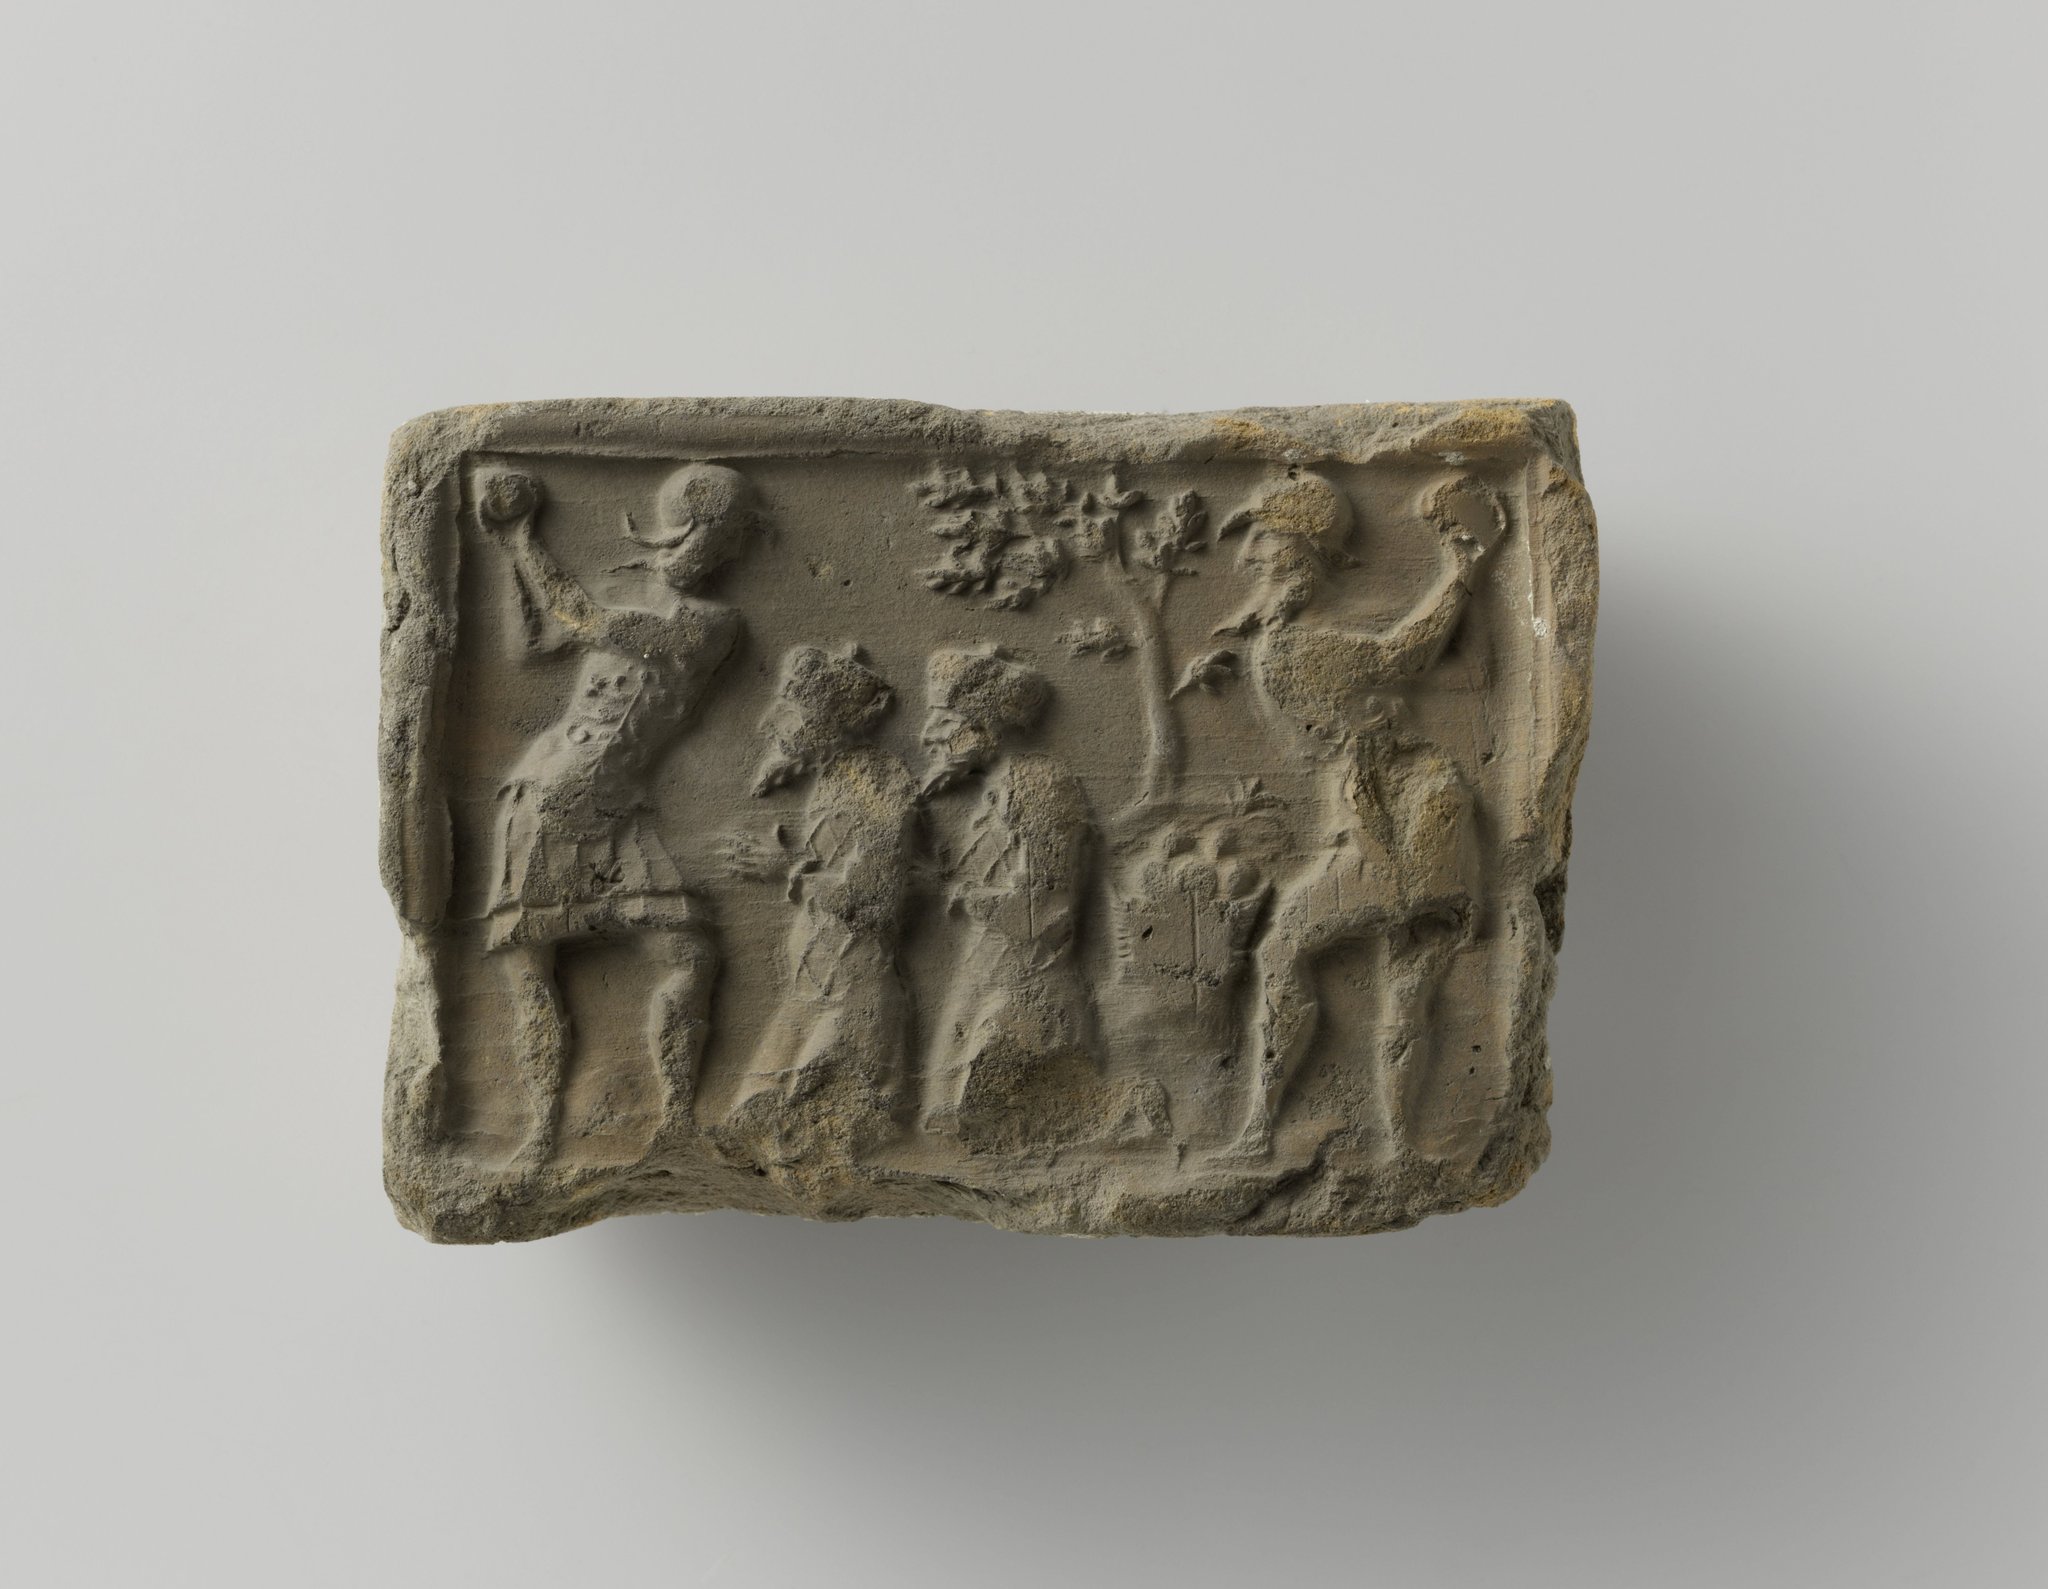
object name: hearthstone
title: Haardsteen met voorstelling van de beide ouderlingen uit de geschiedenis van Suzanna, die door twee soldaten worden gestenigd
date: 1525-1575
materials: earthenware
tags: the elders are stoned to death ~ story of susanna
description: Haardsteen met voorstelling van de beide ouderlingen uit de geschiedenis van Suzanna, die door twee soldaten worden gestenigd.